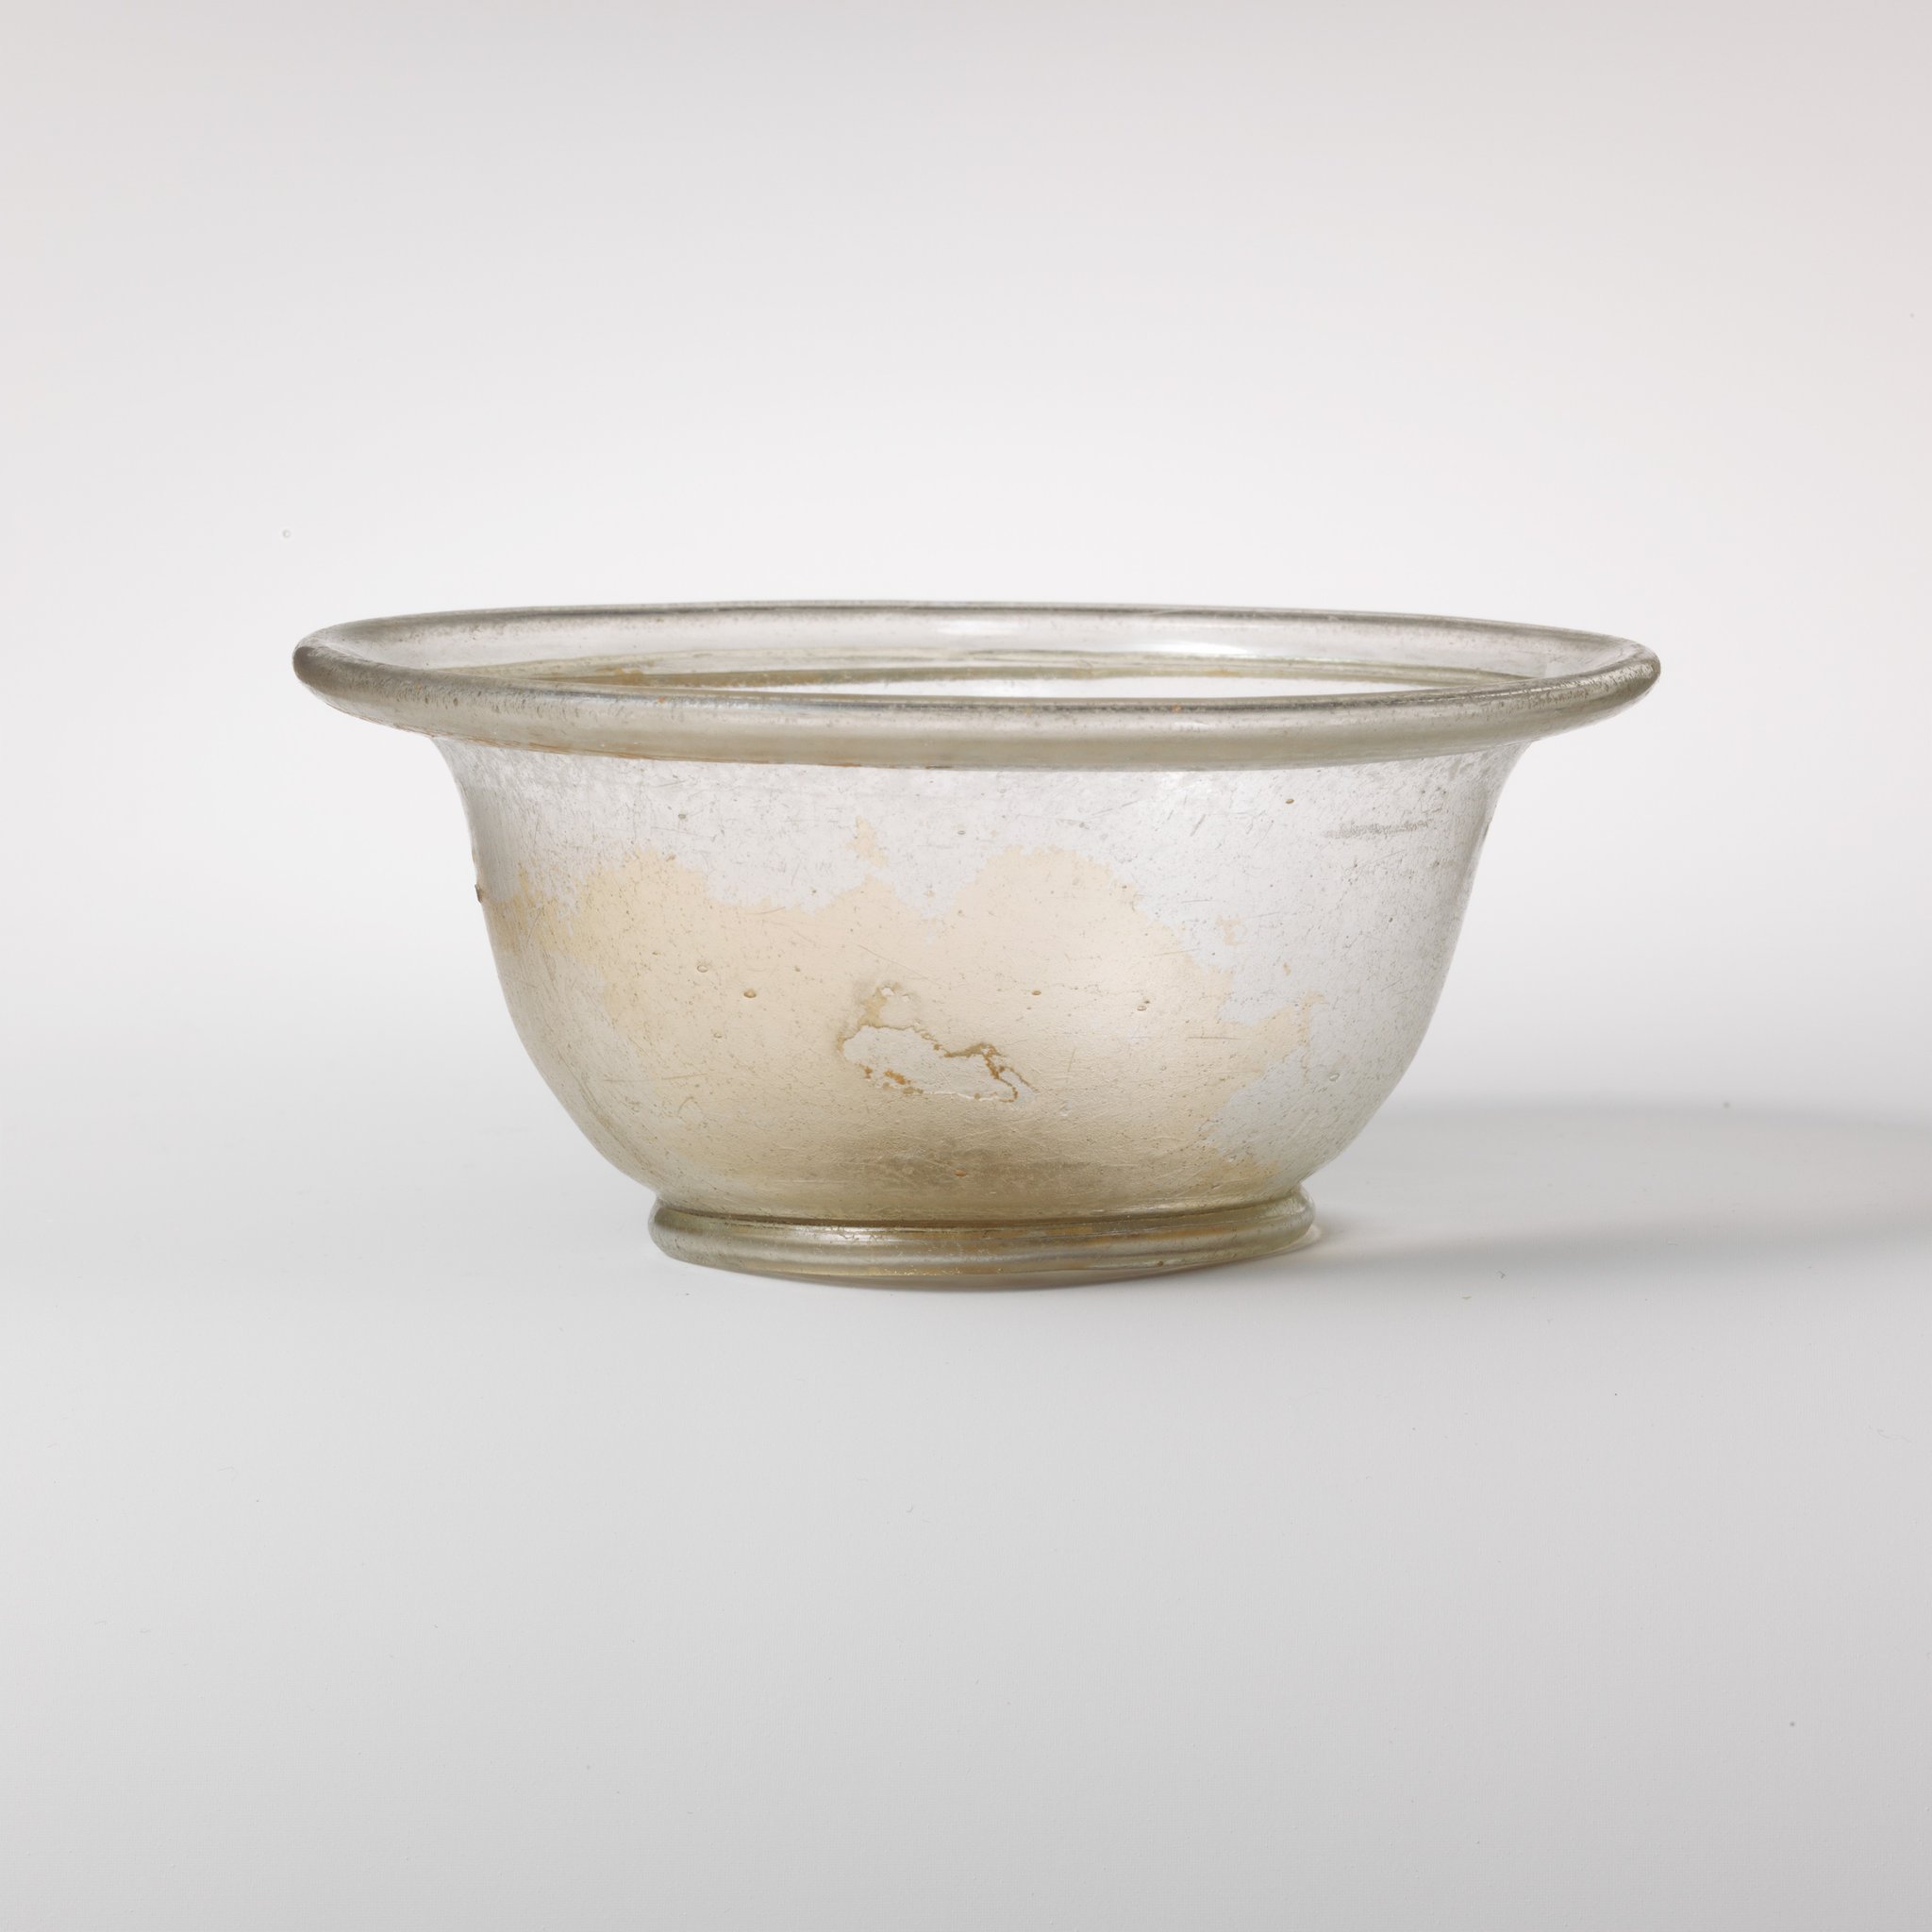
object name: bowl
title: Glass bowl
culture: roman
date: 101-300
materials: glass